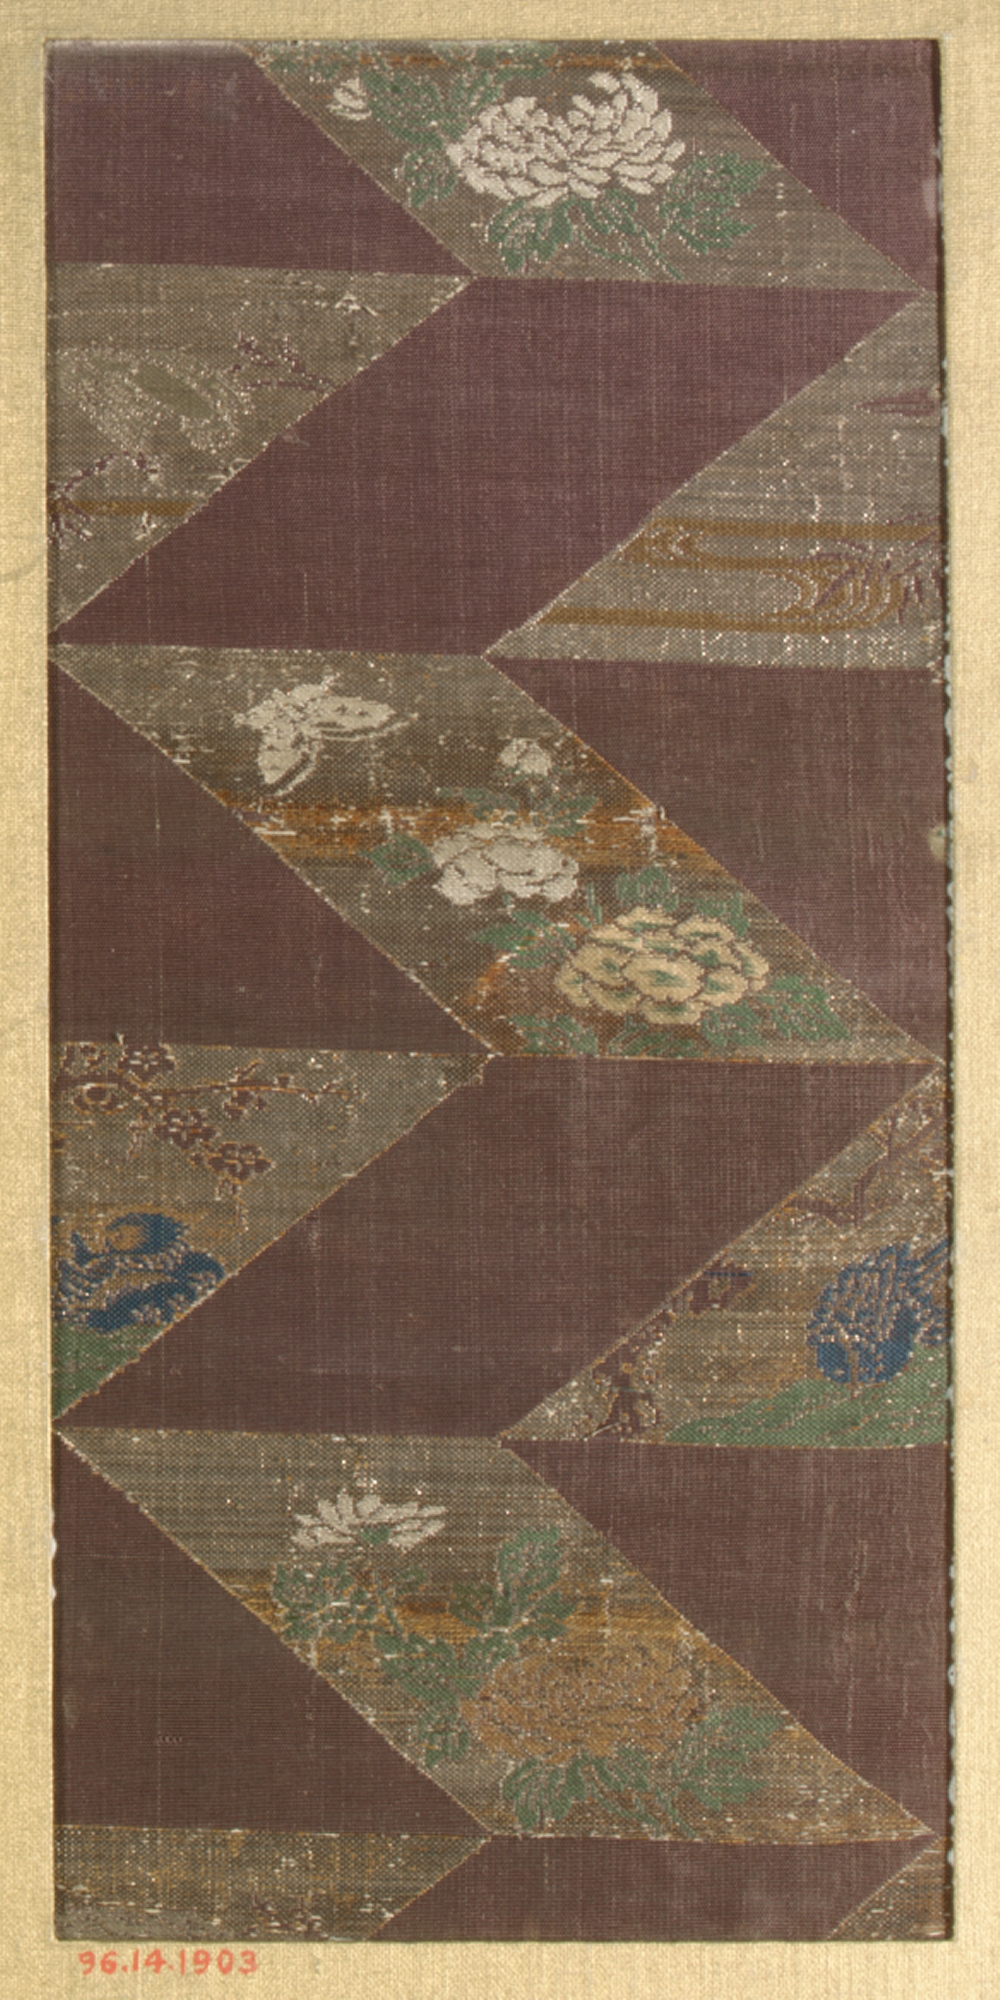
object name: piece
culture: japanese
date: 1701-1900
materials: silk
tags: ducks,butterflies